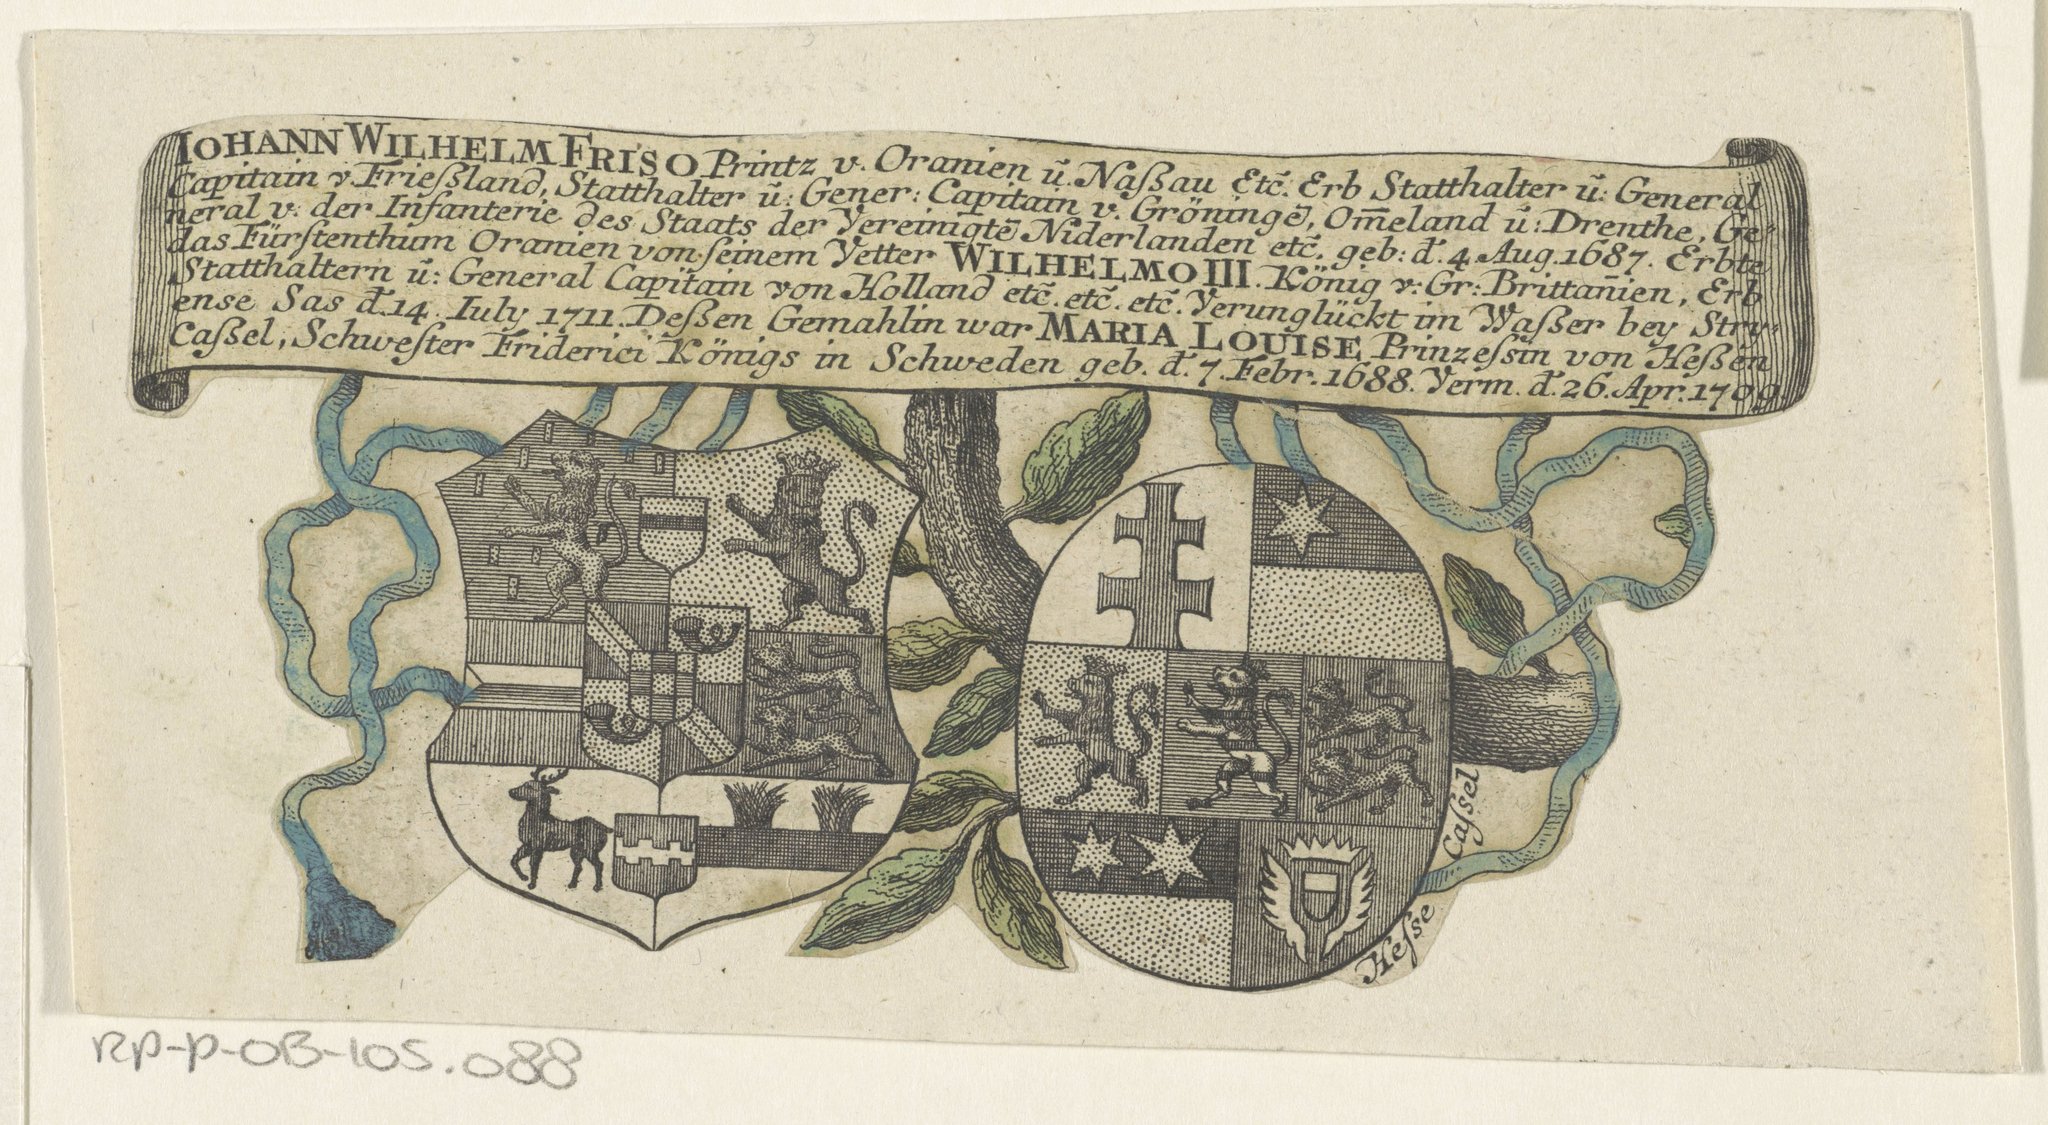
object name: print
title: Wapens van Johan Willem Friso, prins van Oranje-Nassau, en Maria Louisa van Hessen-Kassel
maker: Anonymous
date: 1750-1849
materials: paper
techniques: engraving, hand coloring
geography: low countries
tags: johan willem friso (prins van oranje-nassau)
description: Wapens van Johan Willem Friso en Maria Louisa. In een cartouche zeven regels Nederlandse tekst.